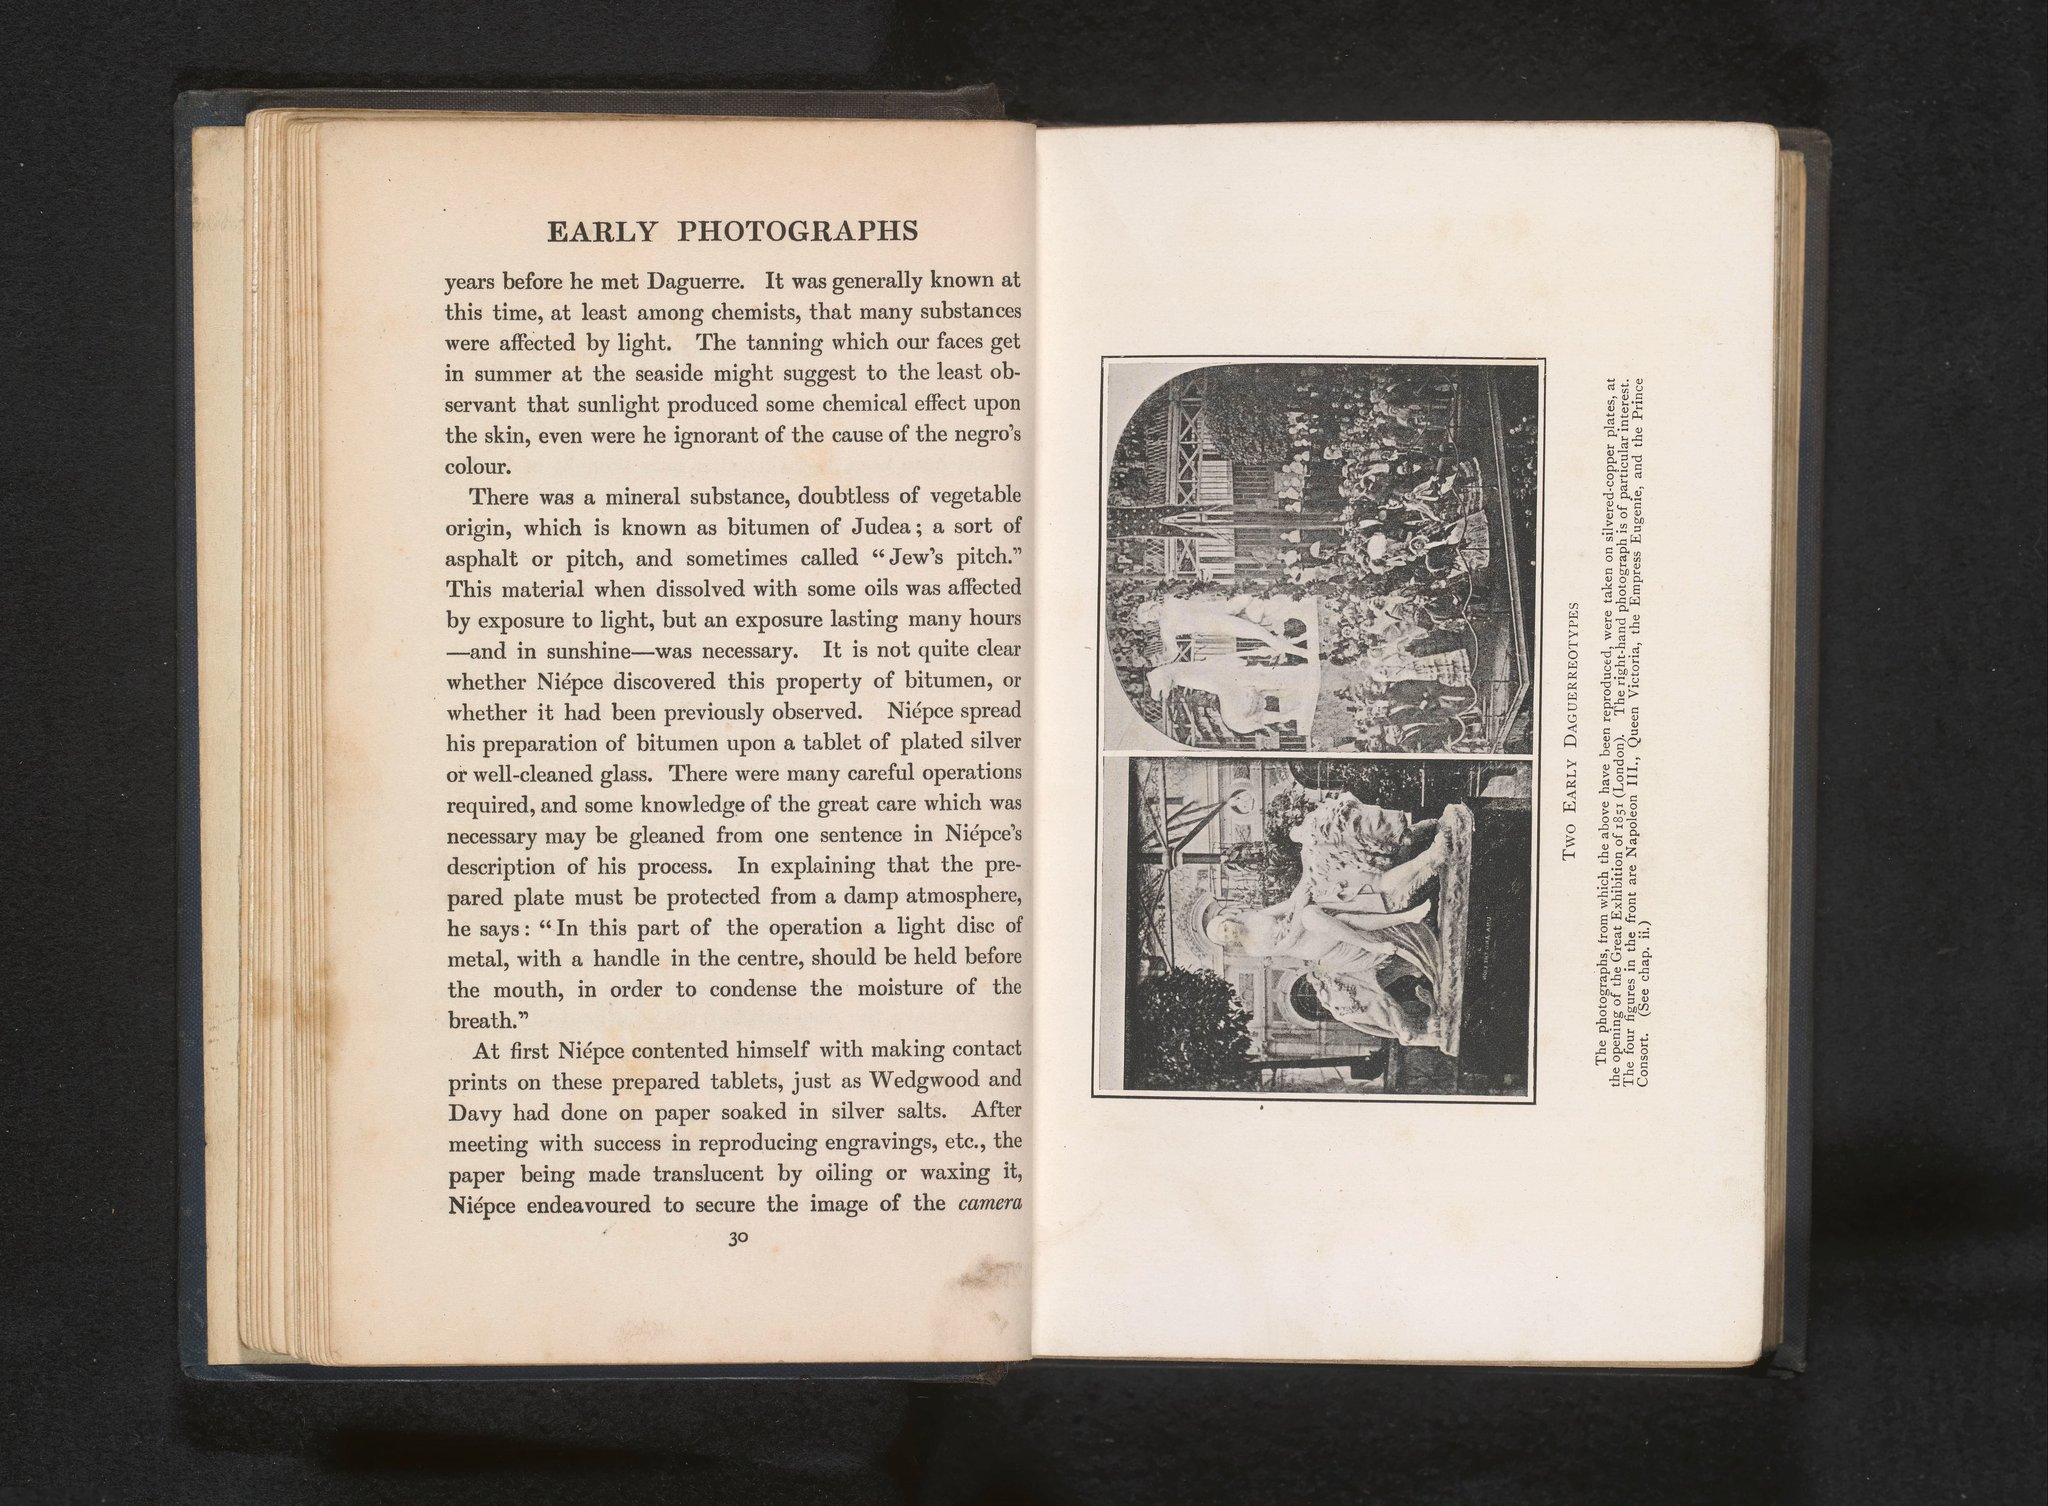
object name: reproduction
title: Fotoreproducties van twee daguerreotypieën van de Wereldtentoonstelling in Londen in 1851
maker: Anonymous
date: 1898-1908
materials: paper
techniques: autotype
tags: world fair, world exhibition, london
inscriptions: inscription: ‘The photographs, from which above have been reproduced, were taken on silver-copper plates, at the opening of the Great Exhibition of 1851 (London). The right-hand photograph is of particular interest. The four figures in the front are Napoleon III., Queen Victoria, The Empress Eugenie, and the Prince Consort. (See chap. ii.)’